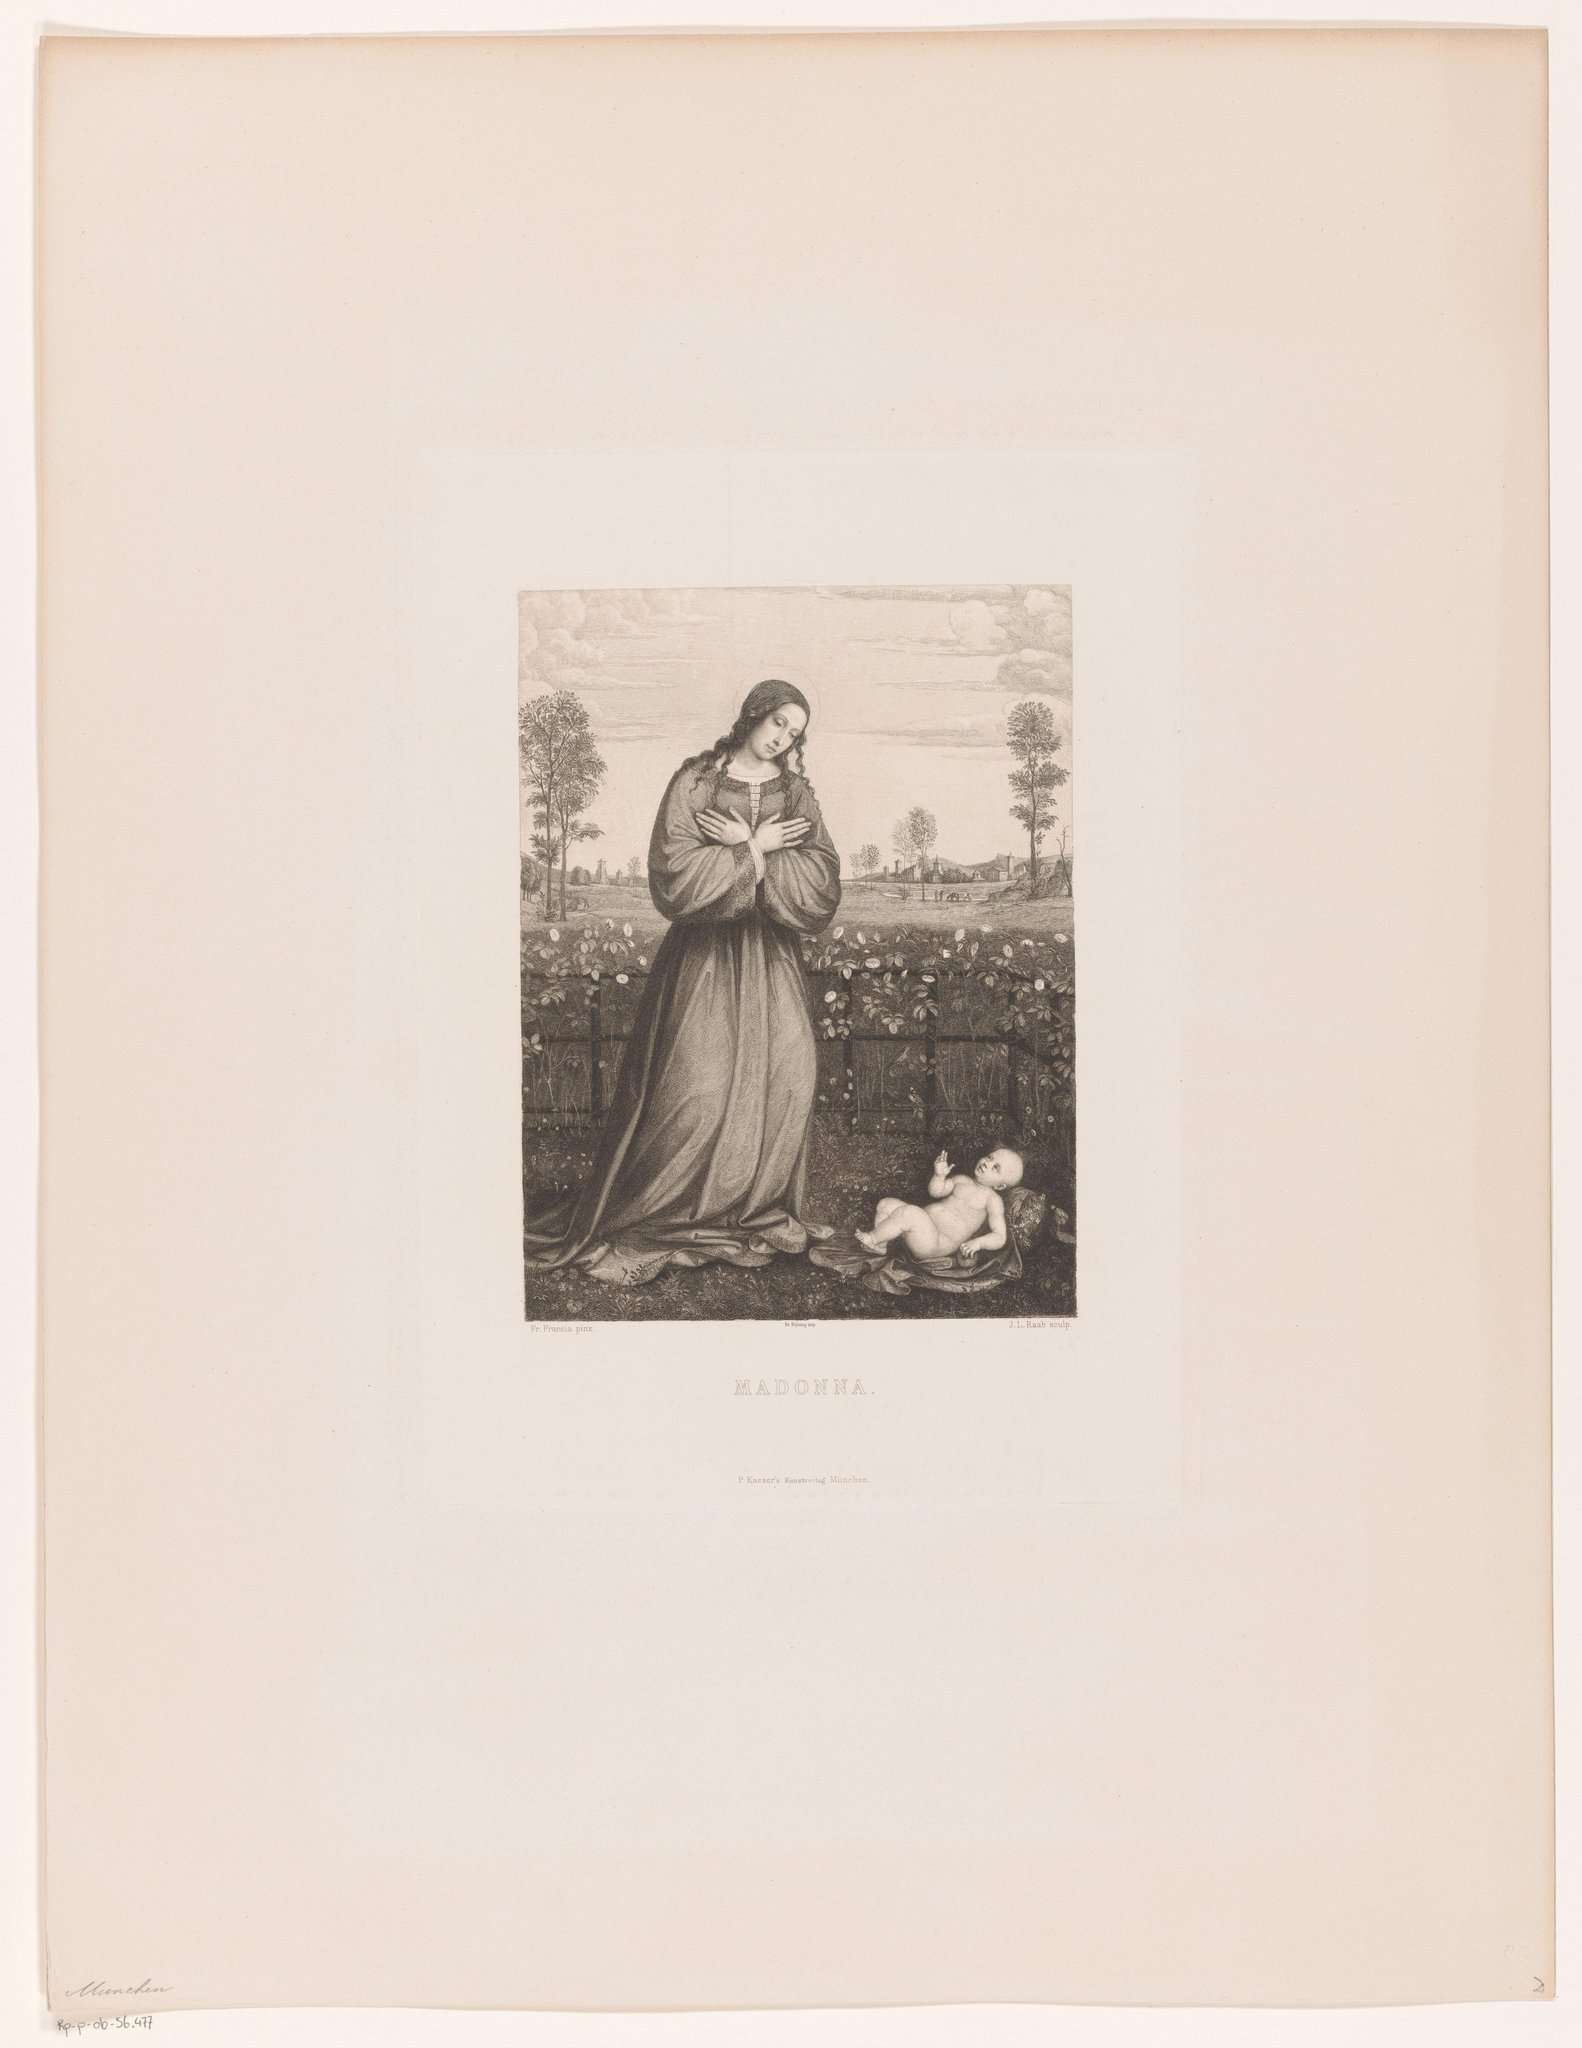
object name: print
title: Maria met kind in een tuin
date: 1835-1899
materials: paper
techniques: etching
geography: munich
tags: 'virgo inter virgines'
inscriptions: collector's mark: Lugt 2228, number: ‘48’